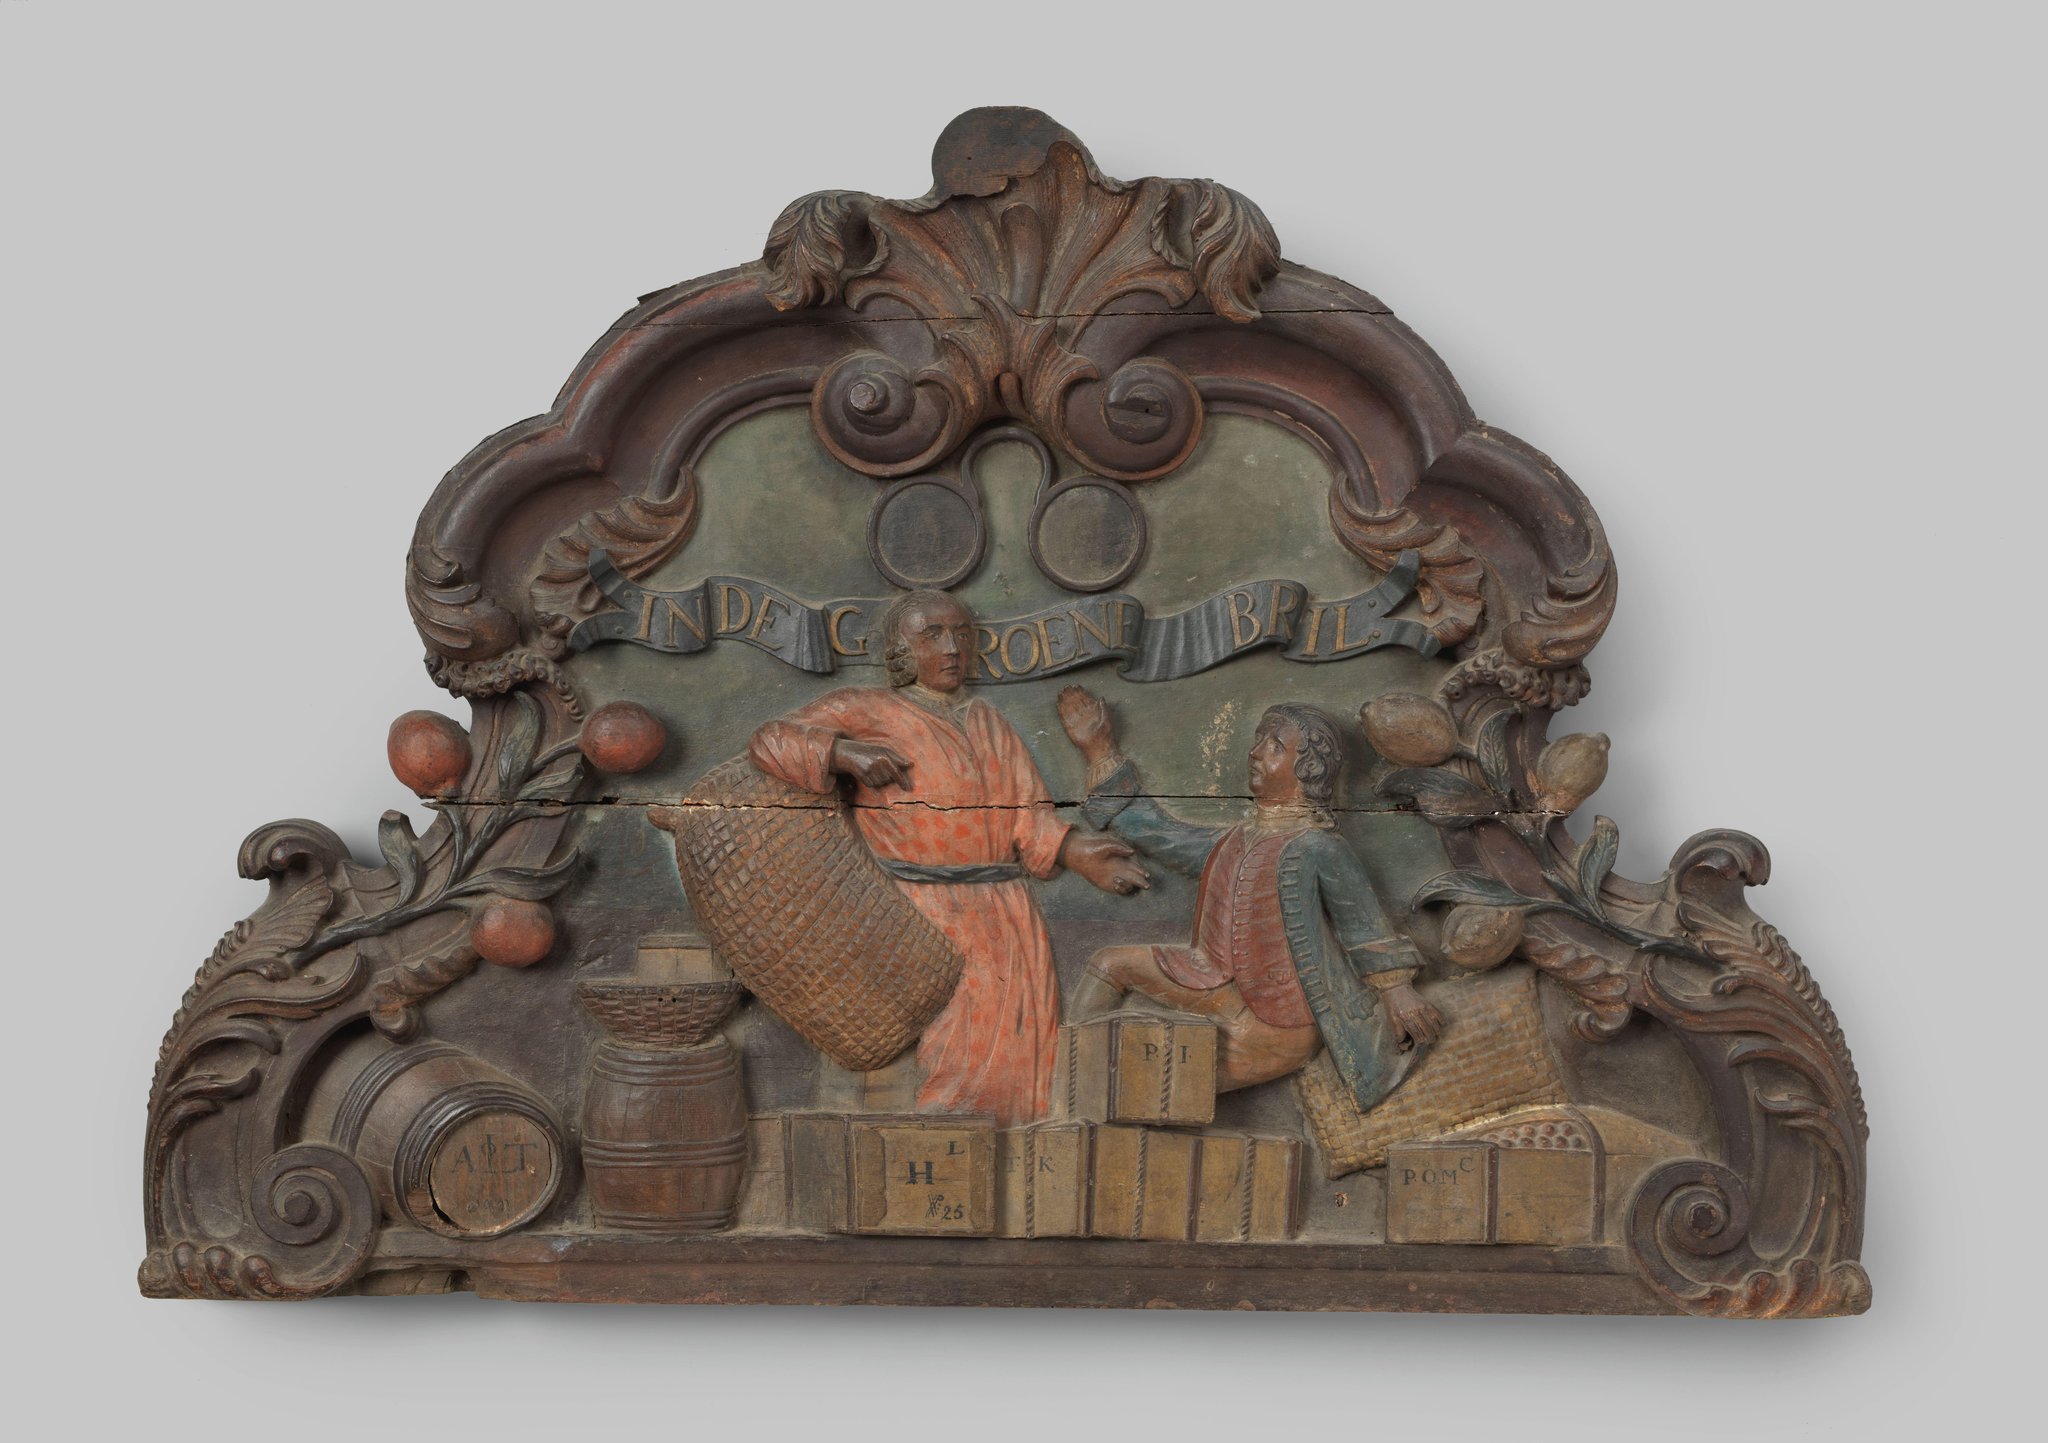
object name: deurbekroning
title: Houten gepolychromeerd uithangbord 'In de groene bril'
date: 1780-1850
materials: wood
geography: netherlands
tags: batavian republic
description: Hoedvormig houten gepolychromeerd bord met een voorstelling in reliëf. Onder een bril redetwisten twee heren temidden van manden en kisten met eigendomsmerken o.a. 'P I' en 'T K' tegen een groene achtergrond. De rechter figuur draagt een vest en laat 18de eews/ 19de eeuwse jas, de linker een soort habijt. De voorstelling wordt omlijst door ranken met vruchten. Daaronder slaat slingerend het opschrift 'In de groene bril'.